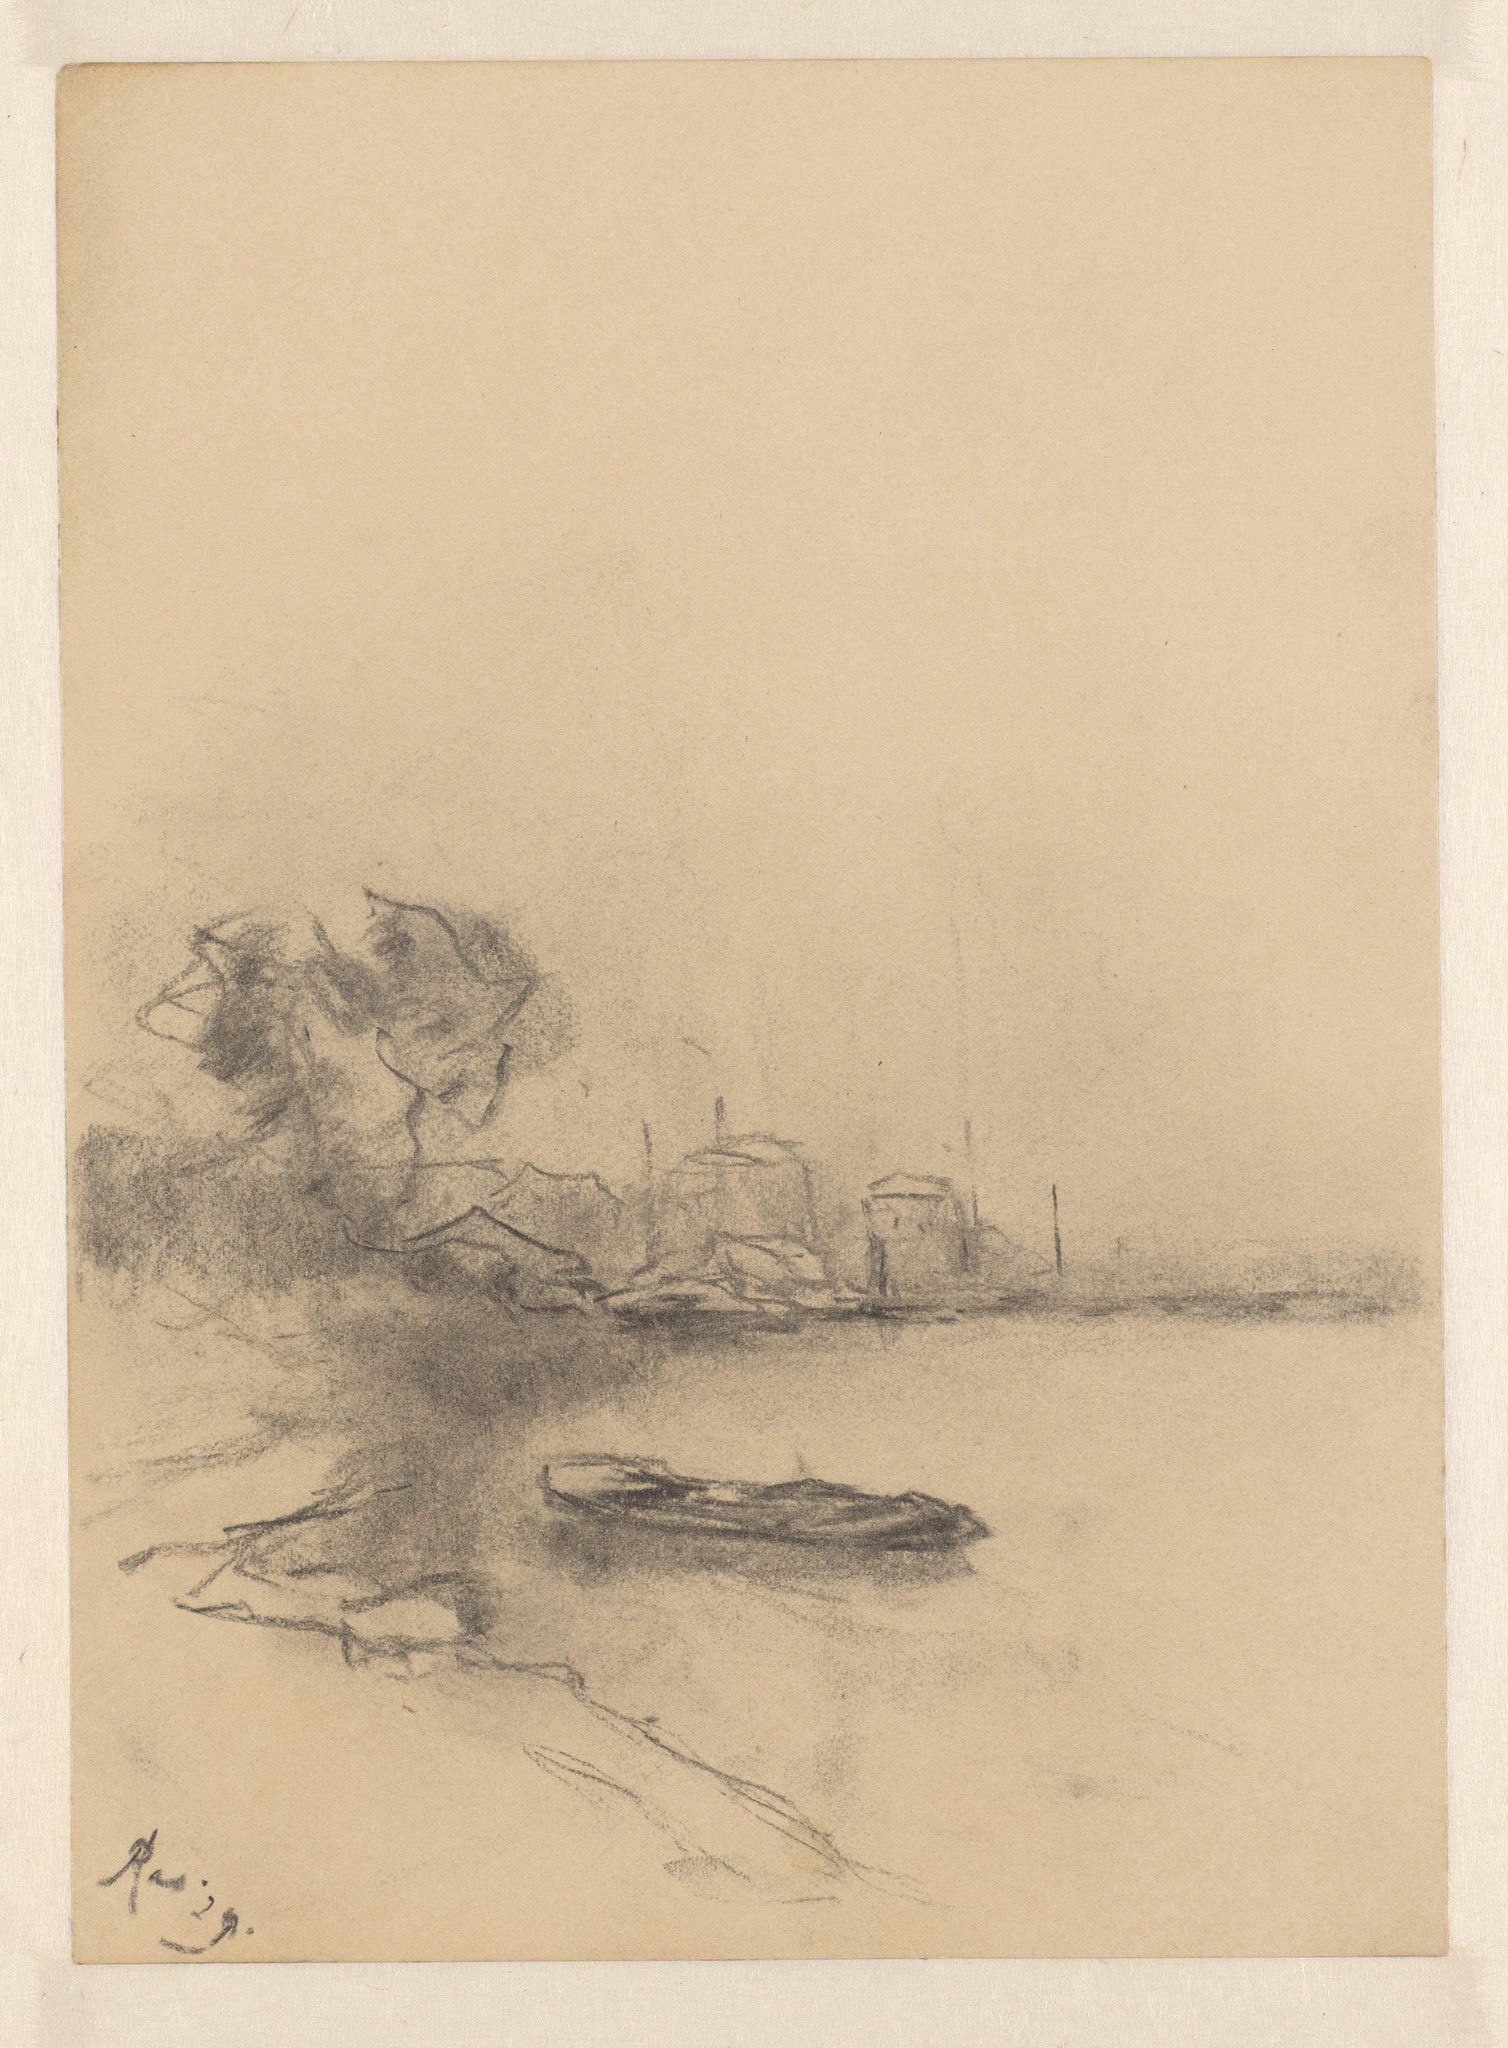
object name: drawing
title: Rivierbocht, in de verte huizen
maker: pieter h.j.j. ras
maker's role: draughtsman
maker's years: 1857-1941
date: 1929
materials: chalk, paper